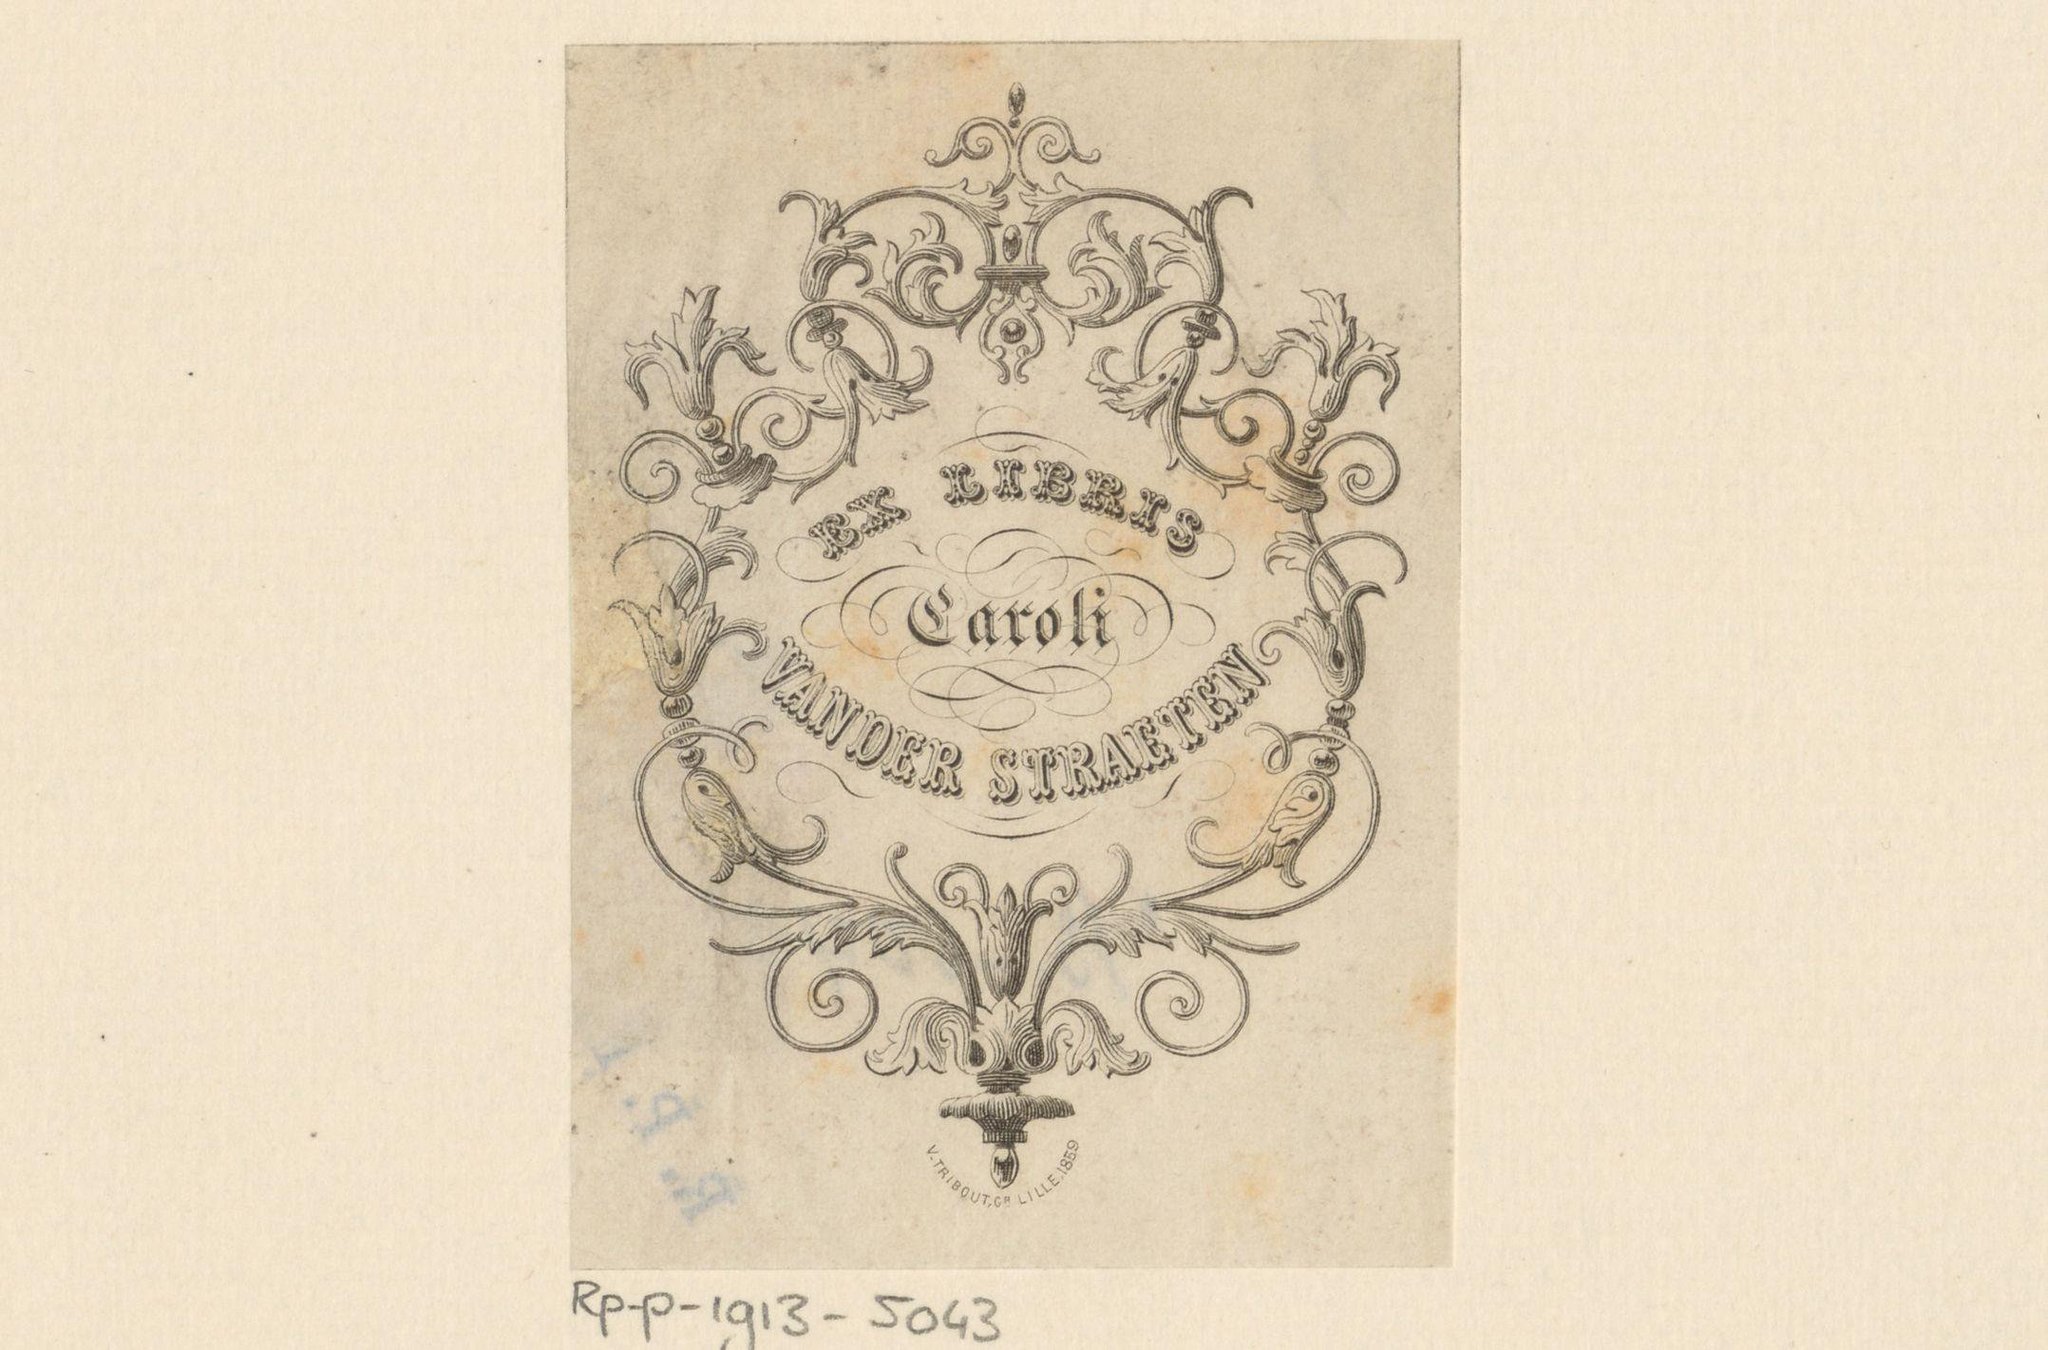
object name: bookplate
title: Ex libris van Caroli van der Straeten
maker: v. tribout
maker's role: print maker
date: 1859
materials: paper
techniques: engraving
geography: lille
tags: acanthus ~ ornament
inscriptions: collector's mark: Lugt 2760, collector's mark: Lugt 2233